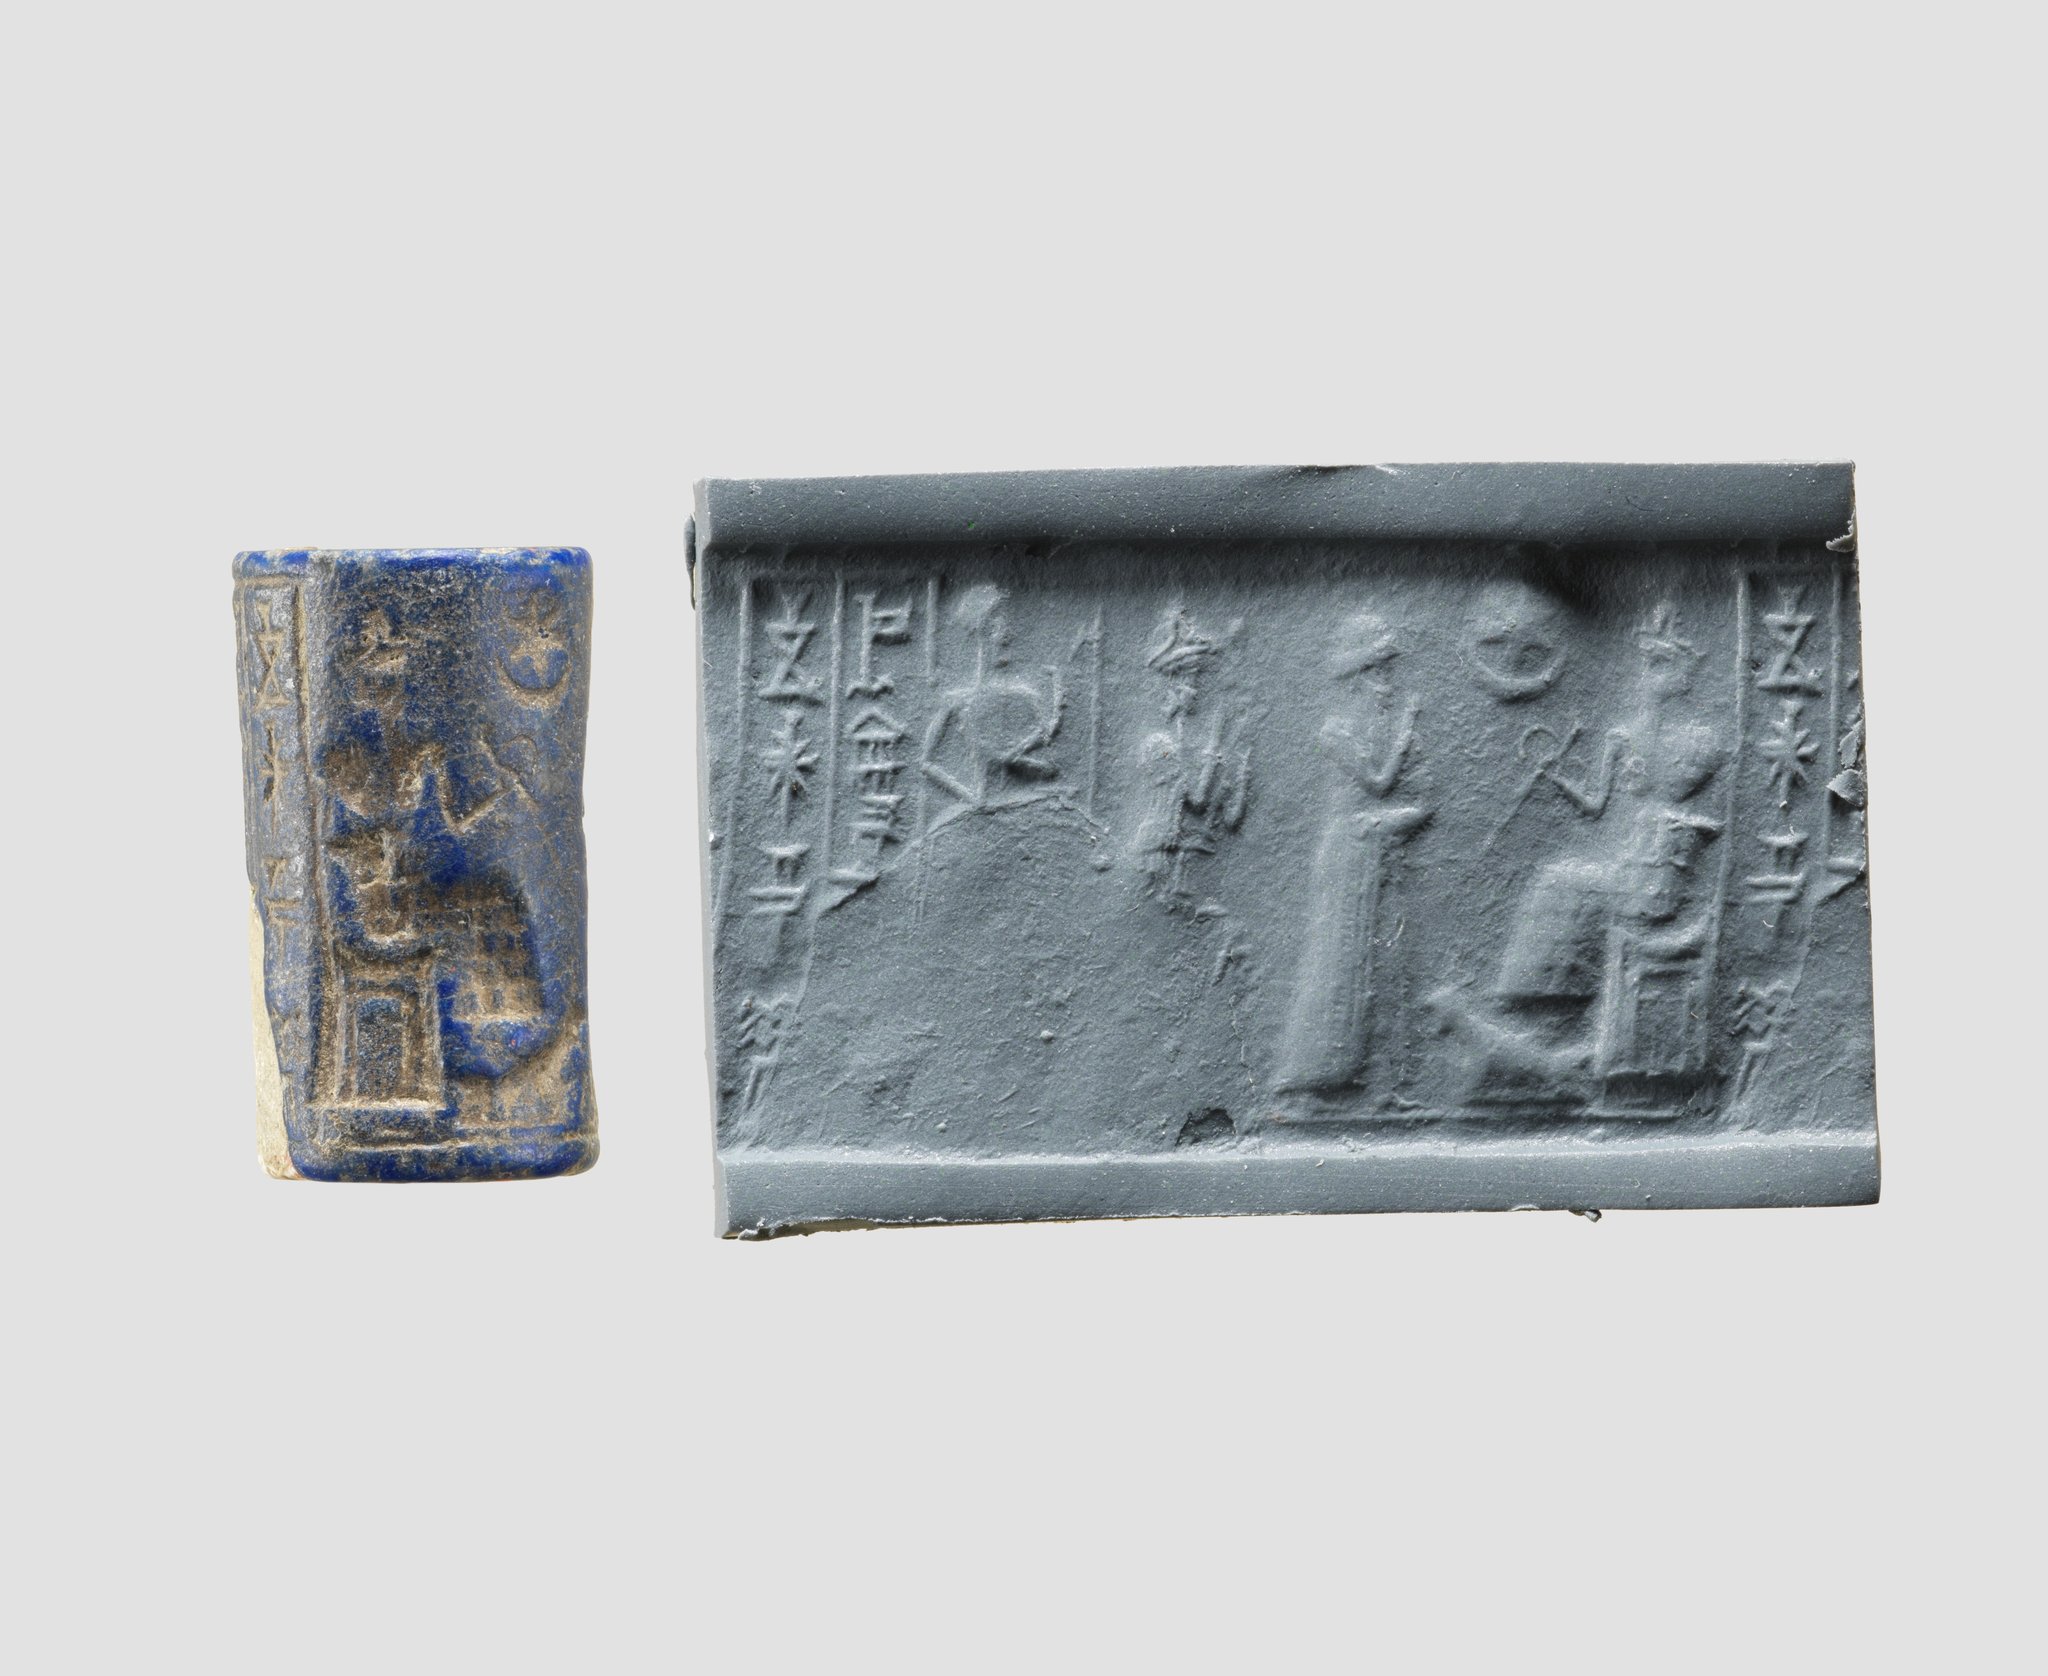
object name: cylinder seal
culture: babylonian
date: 1900-1501 BCE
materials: lapis lazuli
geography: mesopotamia